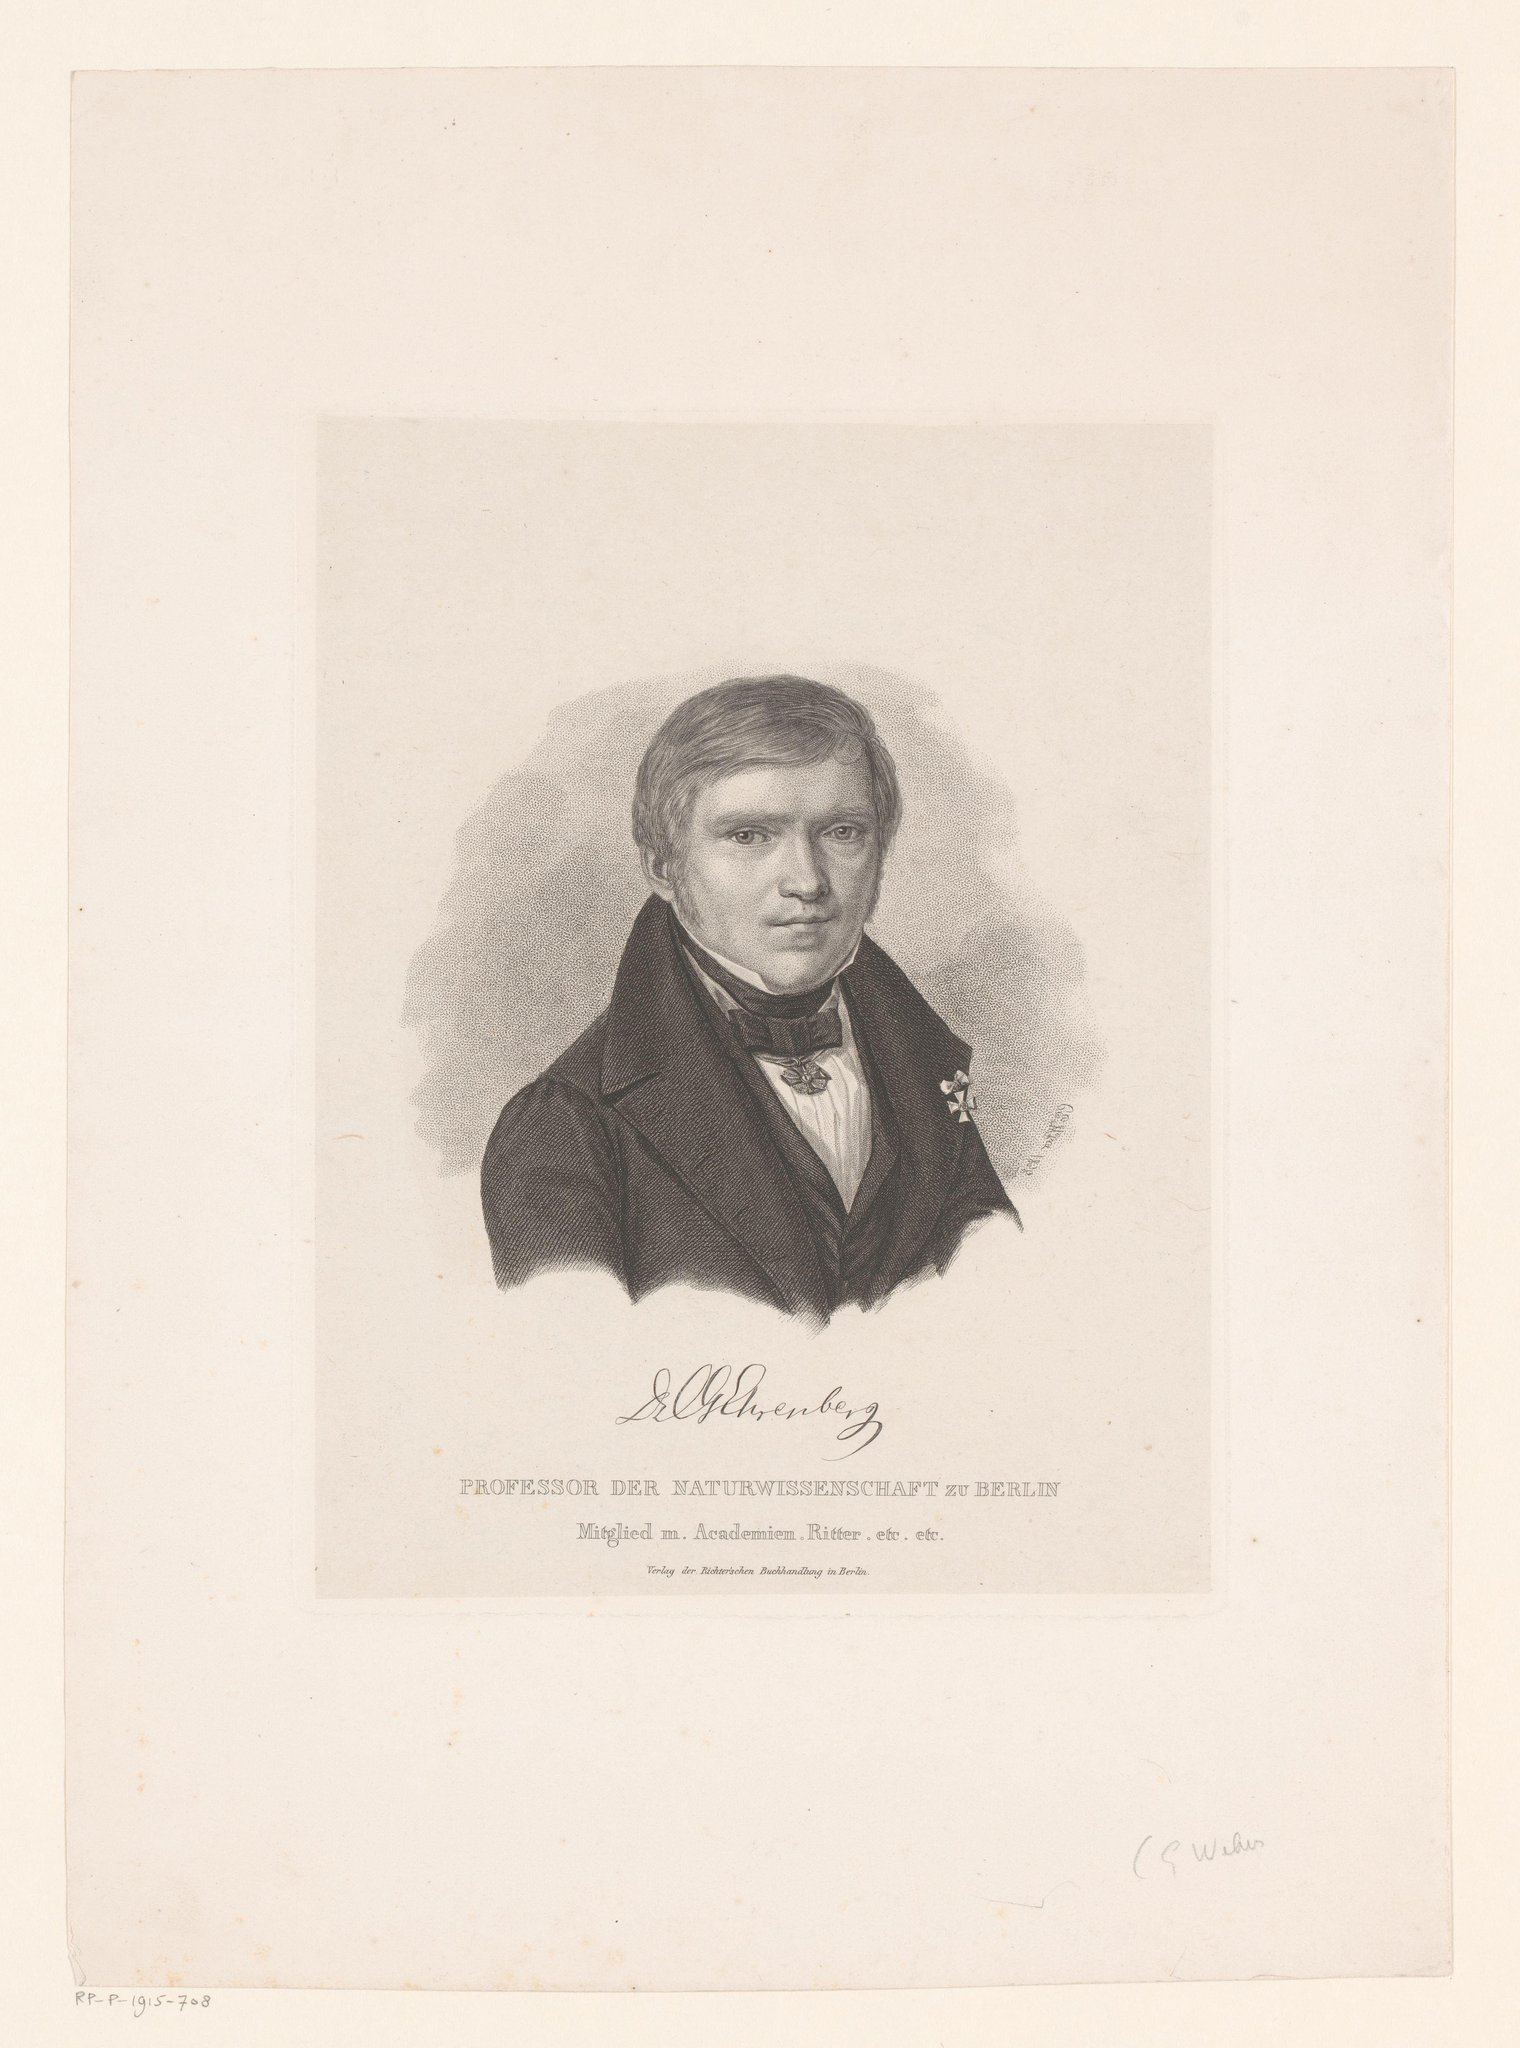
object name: print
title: Portret van Christian Gottfried Ehrenberg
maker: karl eduard weber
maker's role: draughtsman, painter, print maker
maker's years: 1806-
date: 1838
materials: paper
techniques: engraving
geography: berlin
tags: berlin, historical persons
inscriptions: collector's mark: Lugt 2228